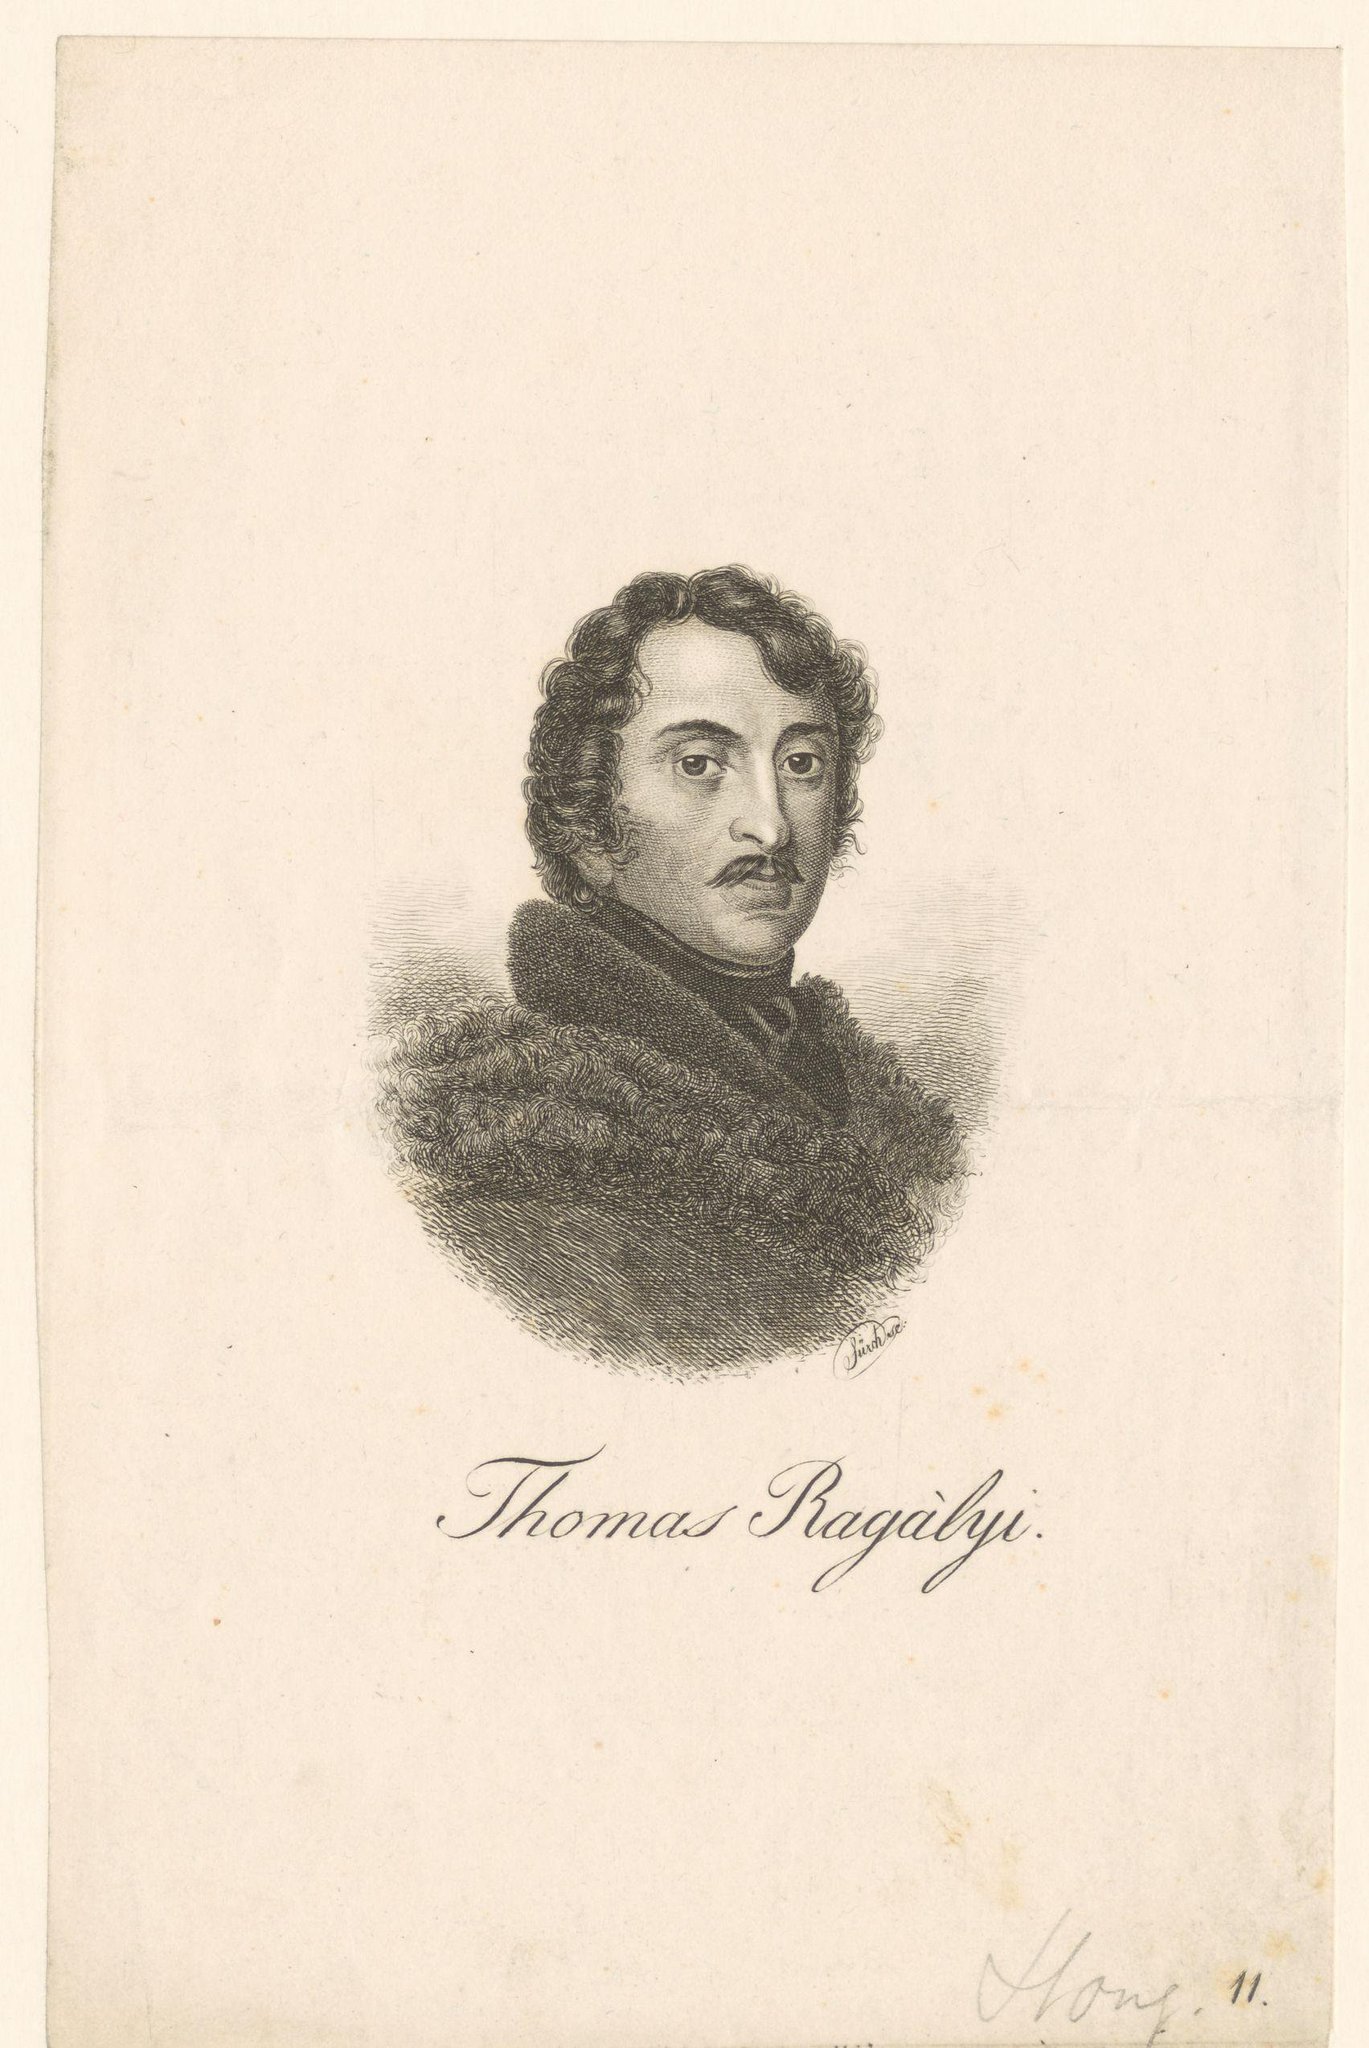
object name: print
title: Portret van Thomas Ragàlyi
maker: joseph sürch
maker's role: print maker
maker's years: 1811-1877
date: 1821-1877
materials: paper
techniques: etching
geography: vienna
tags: historical persons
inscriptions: collector's mark: Lugt 2228